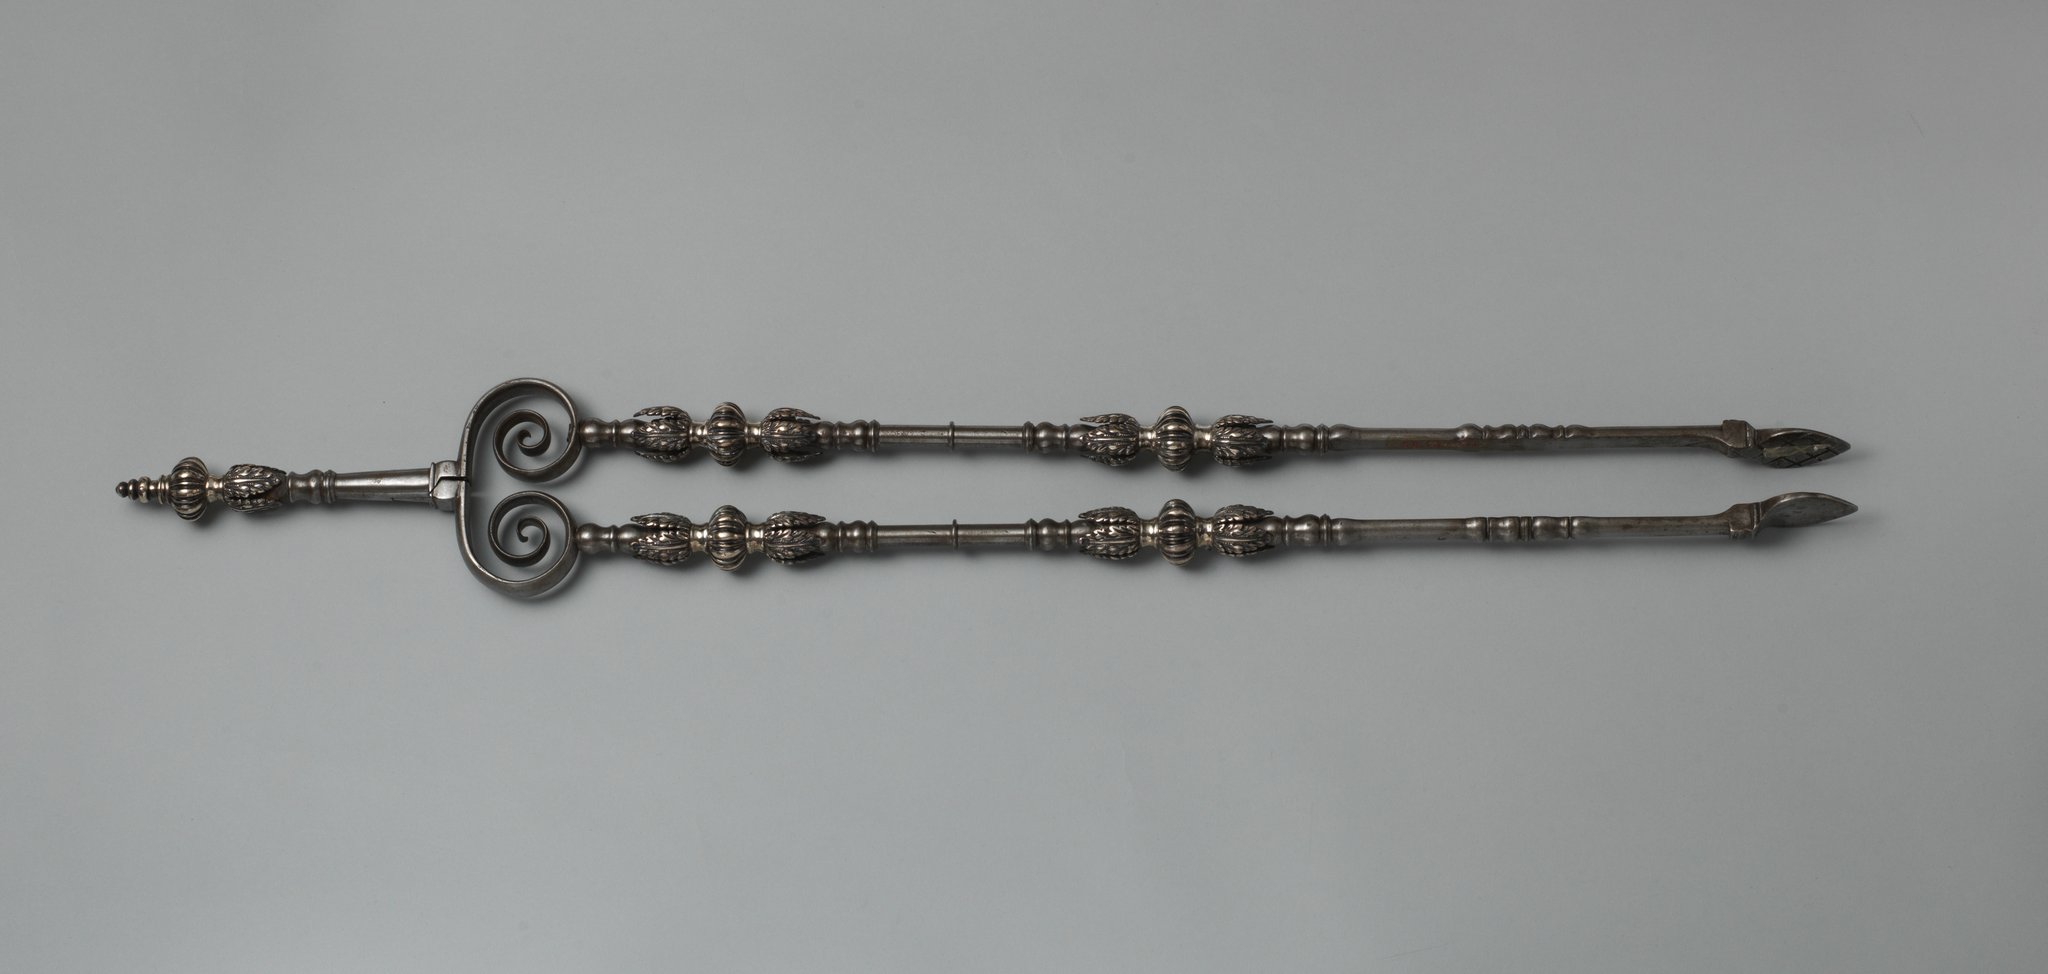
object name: tongs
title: Tongs (part of a set)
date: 1675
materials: iron, silver